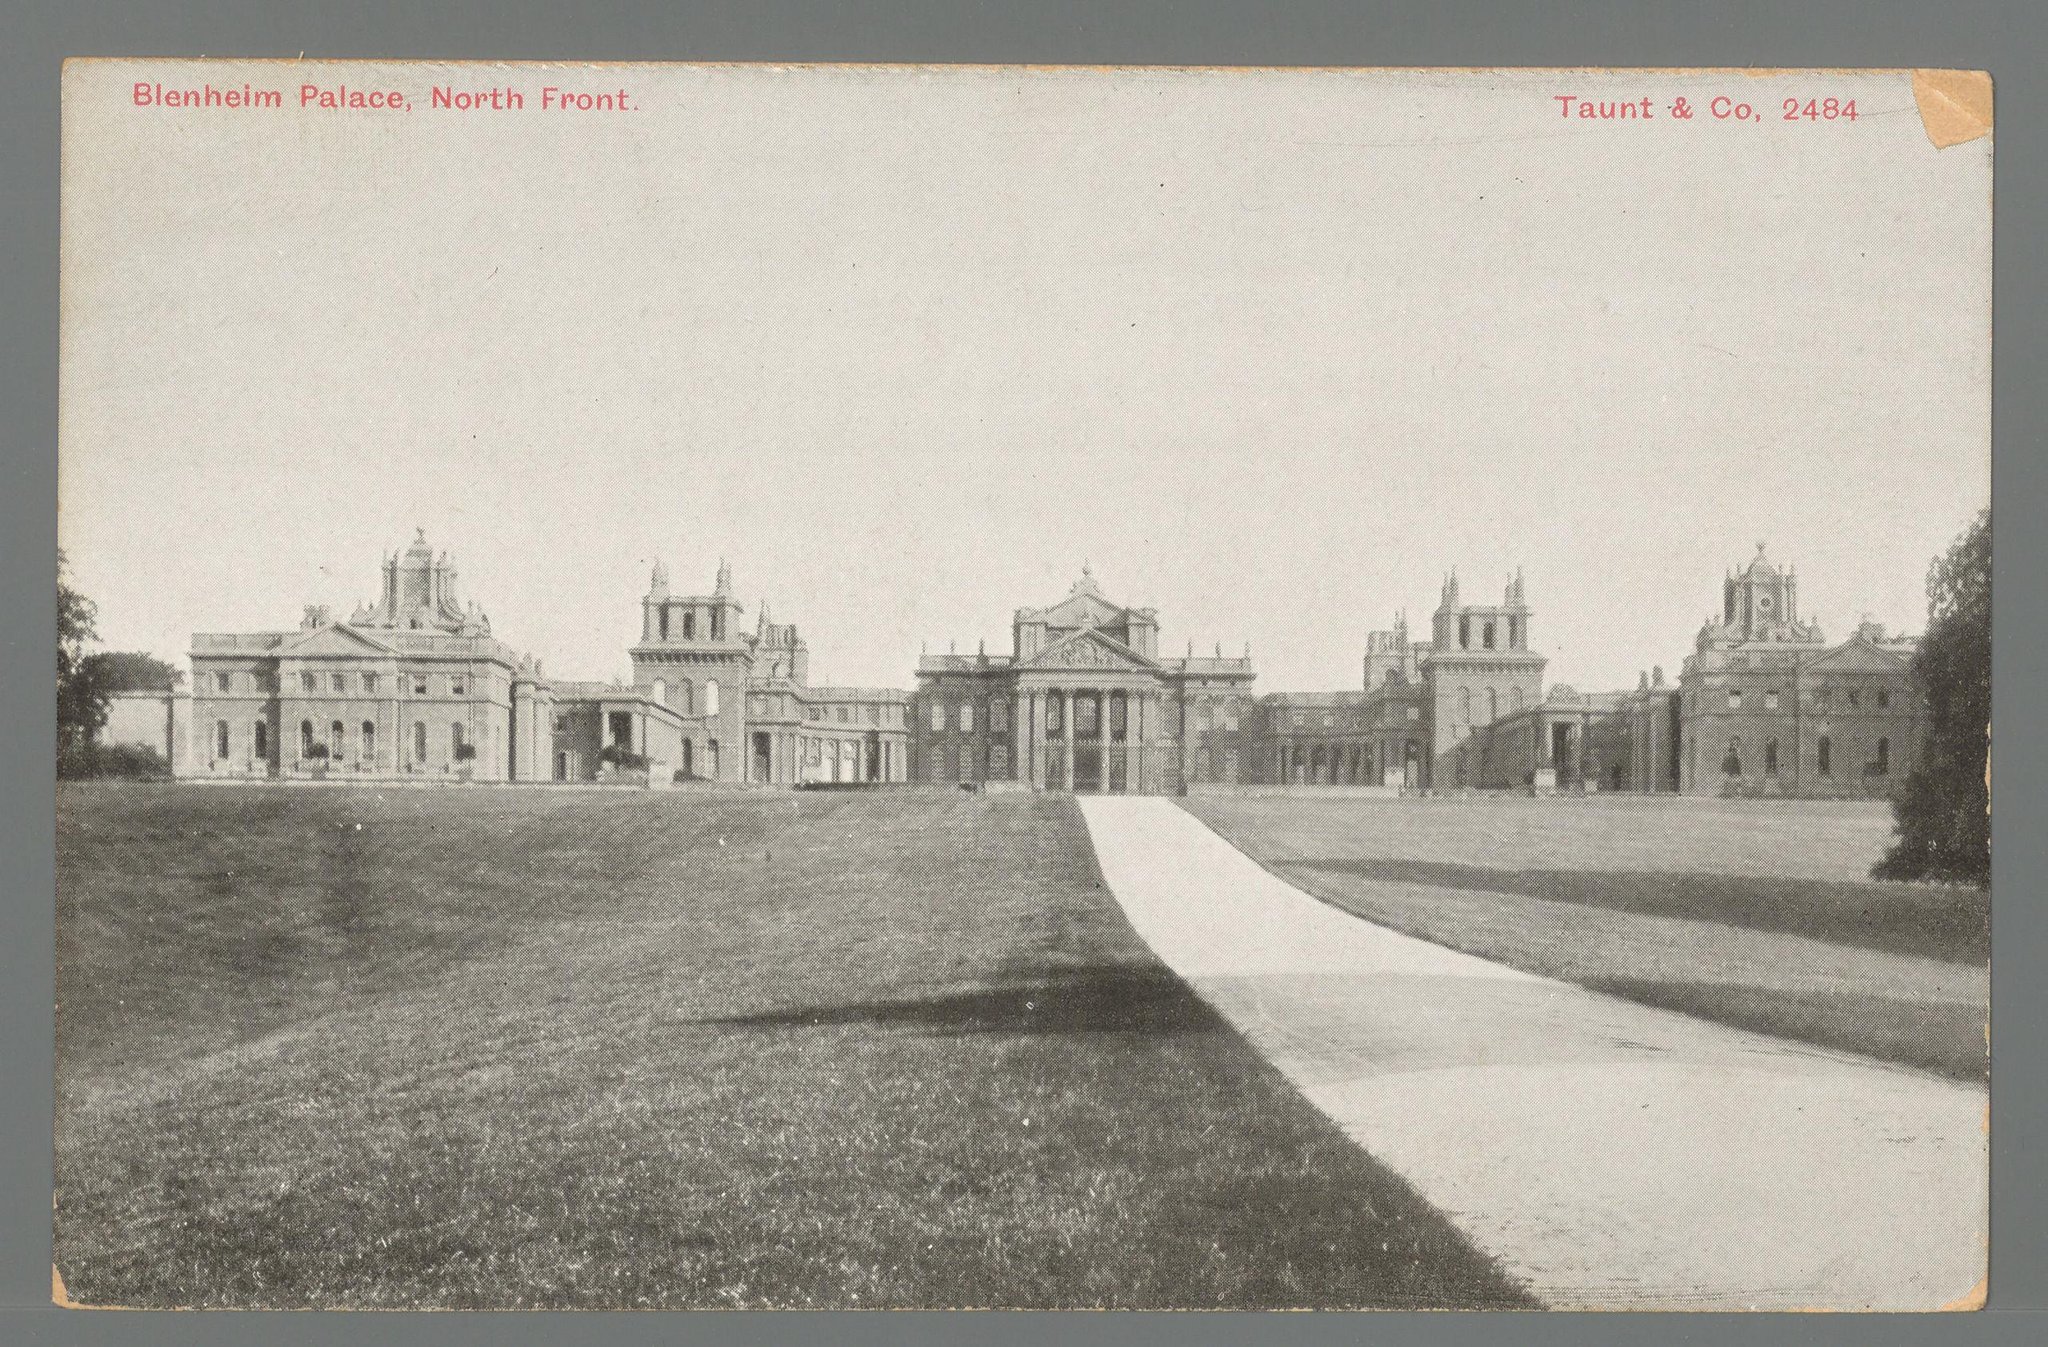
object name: ansichtkaart, prentbriefkaart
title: Blenheim Palace, North Front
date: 1902-1909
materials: cardboard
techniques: writing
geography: oxfordshire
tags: palace